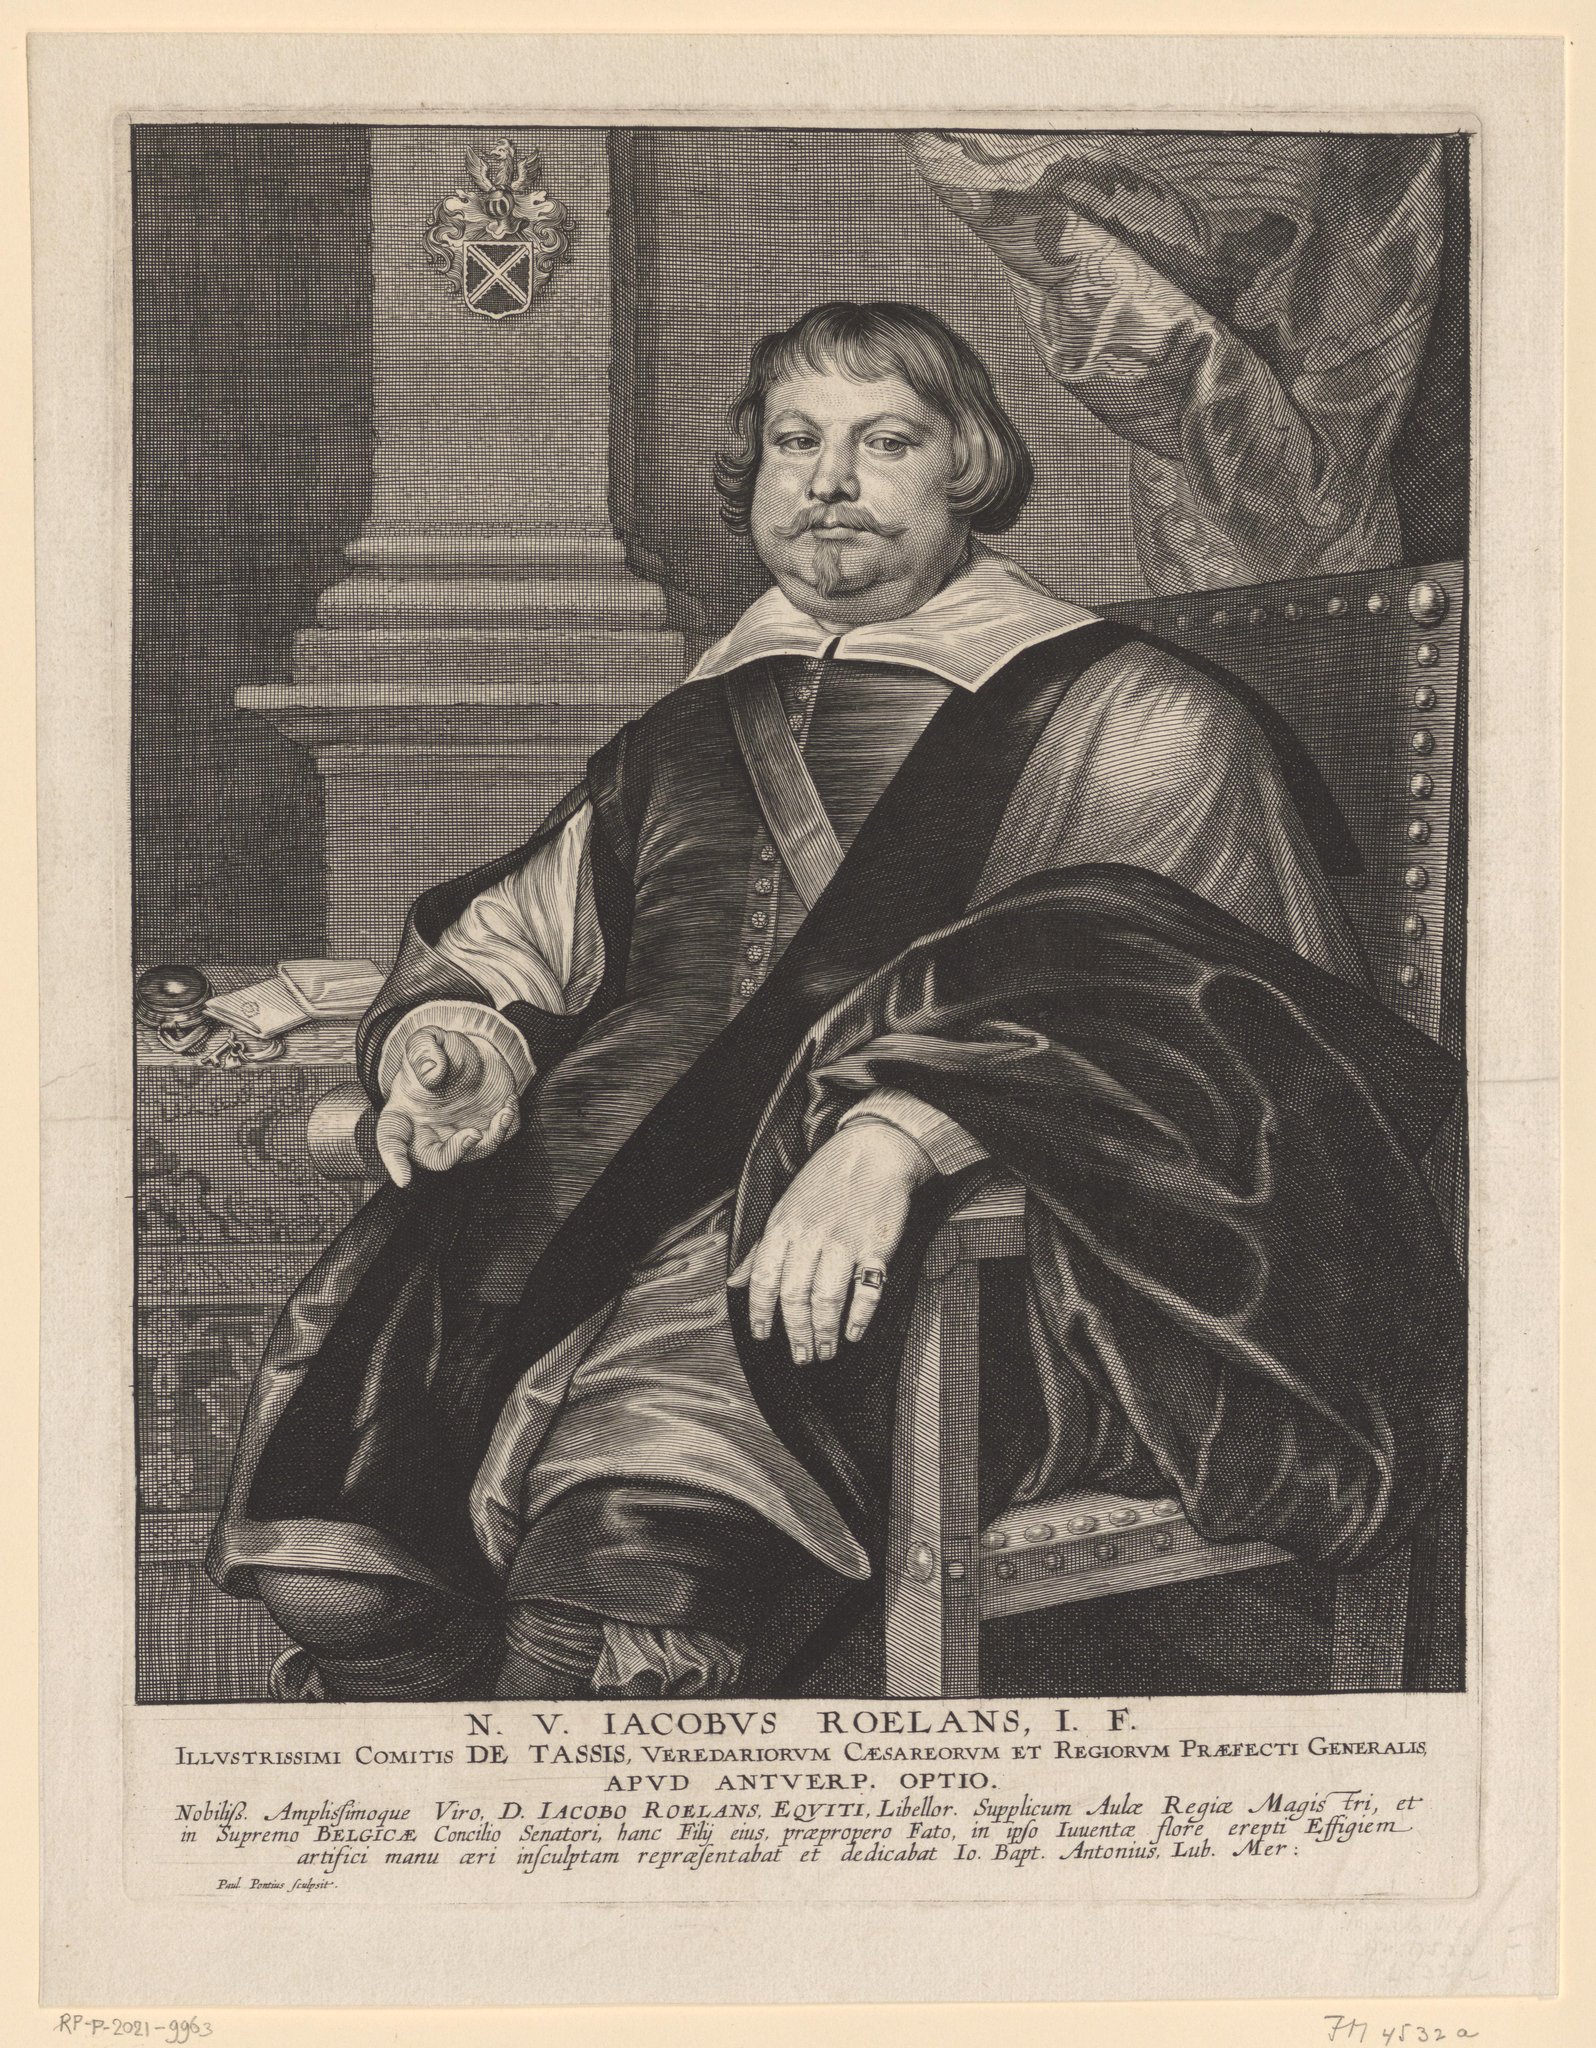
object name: print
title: Portret van Jacob Roelants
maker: paulus pontius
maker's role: draughtsman, print maker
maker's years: 1603-1658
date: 1616-1657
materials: paper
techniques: engraving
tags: historical persons, armorial bearing, heraldry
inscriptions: collector's mark: Lugt 789a, collector's mark: Lugt 2228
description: Linksboven het portret zijn wapenschild.